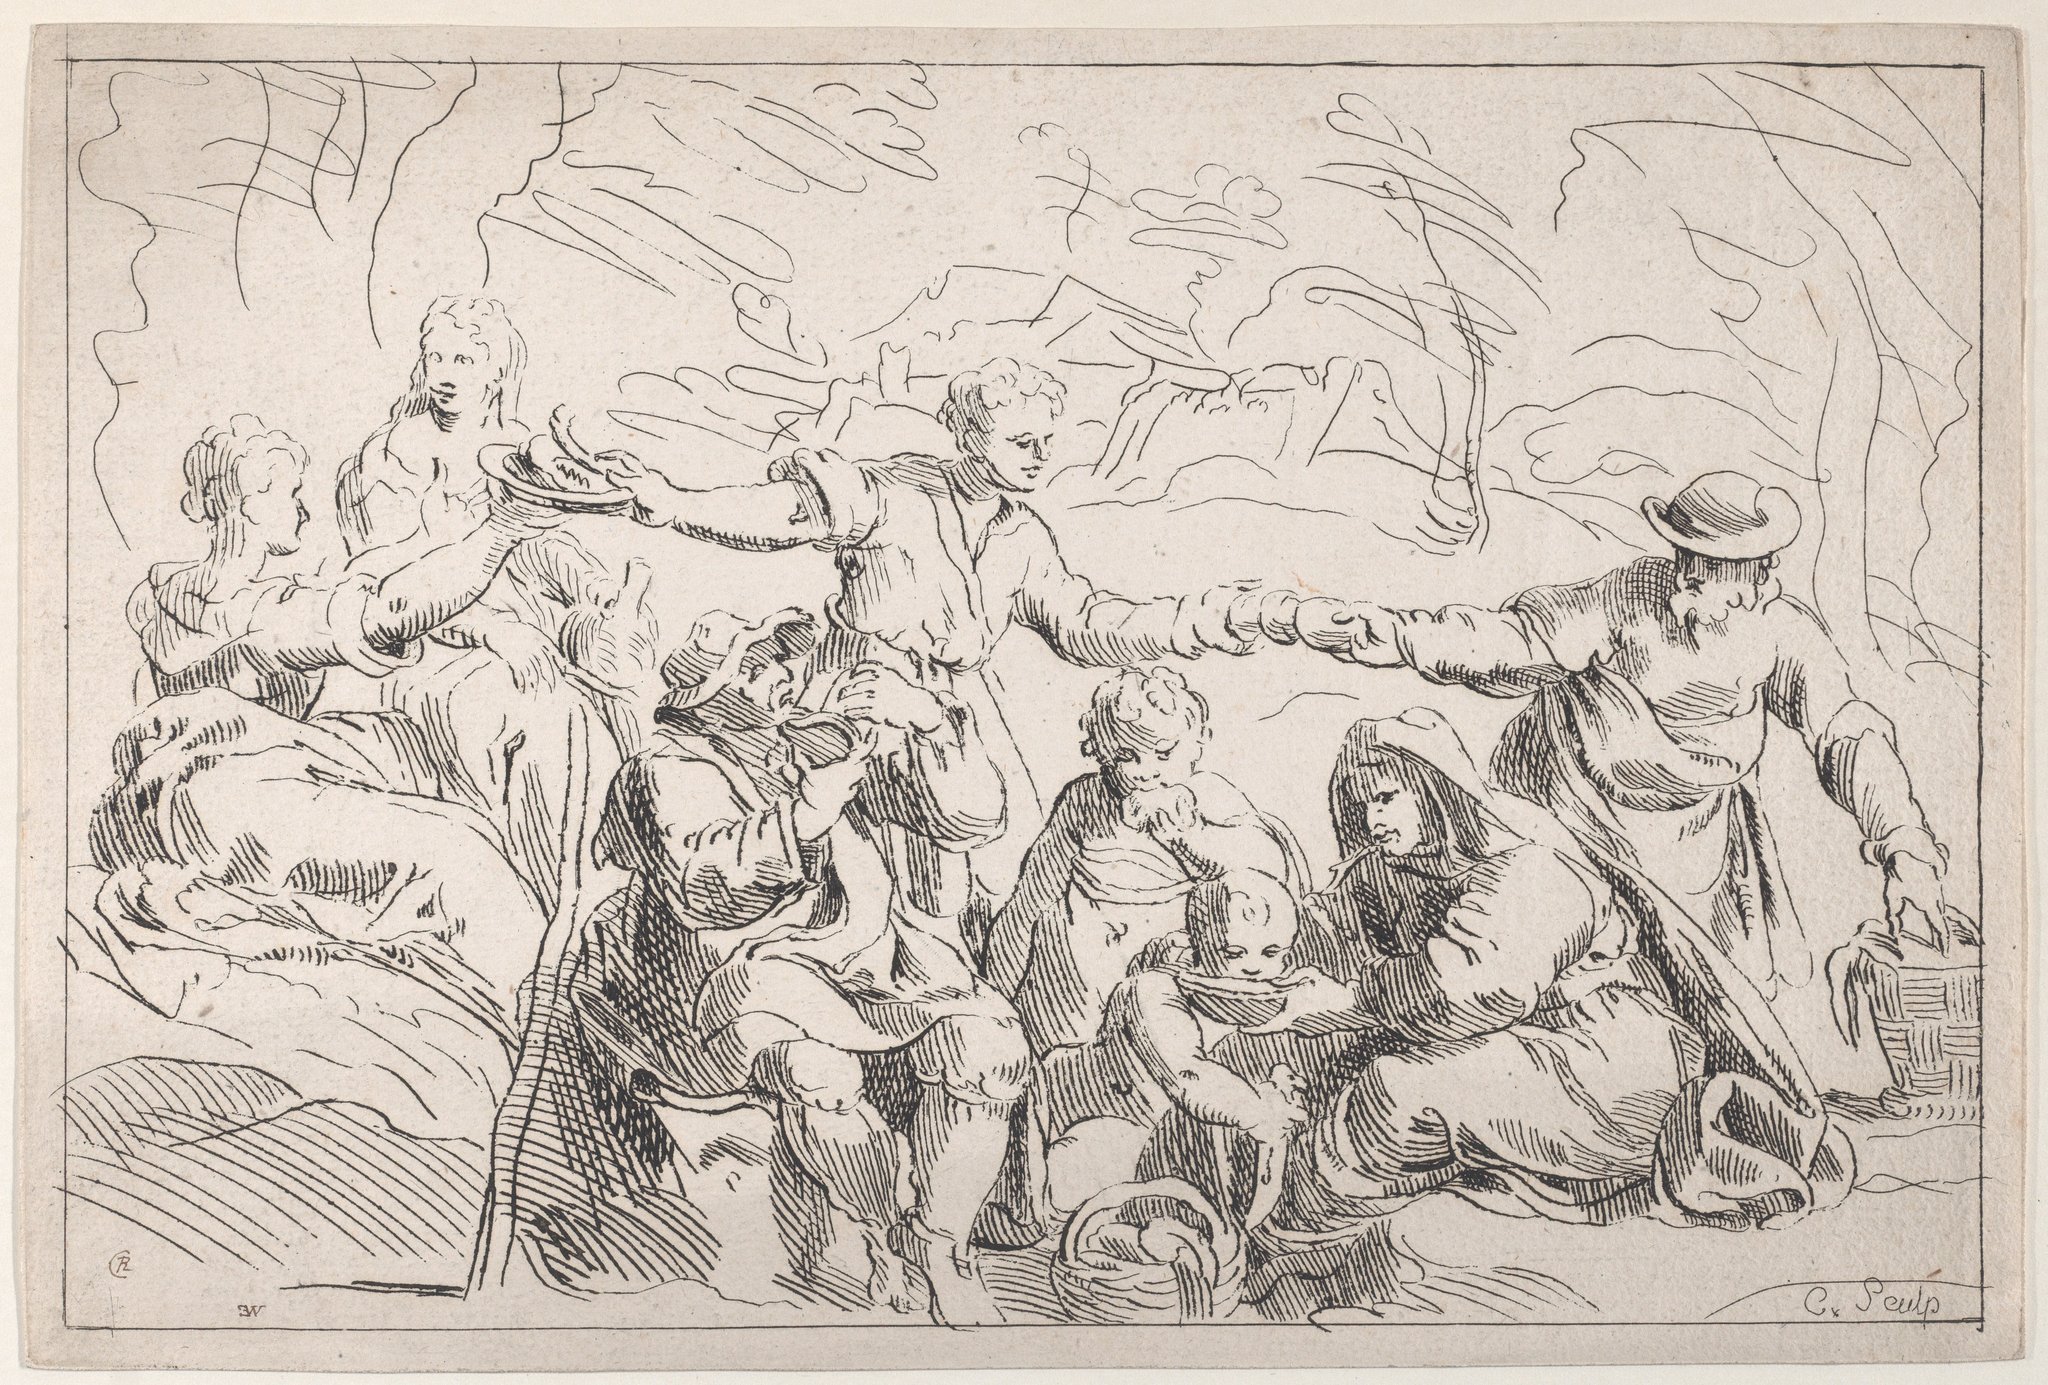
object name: print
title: A Party Eating Outdoors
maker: anne claude philippe de tubières, comte de caylus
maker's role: artist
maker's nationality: french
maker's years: 1692-1765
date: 1701-1800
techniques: etching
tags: food,children,men,women,drinking,eating